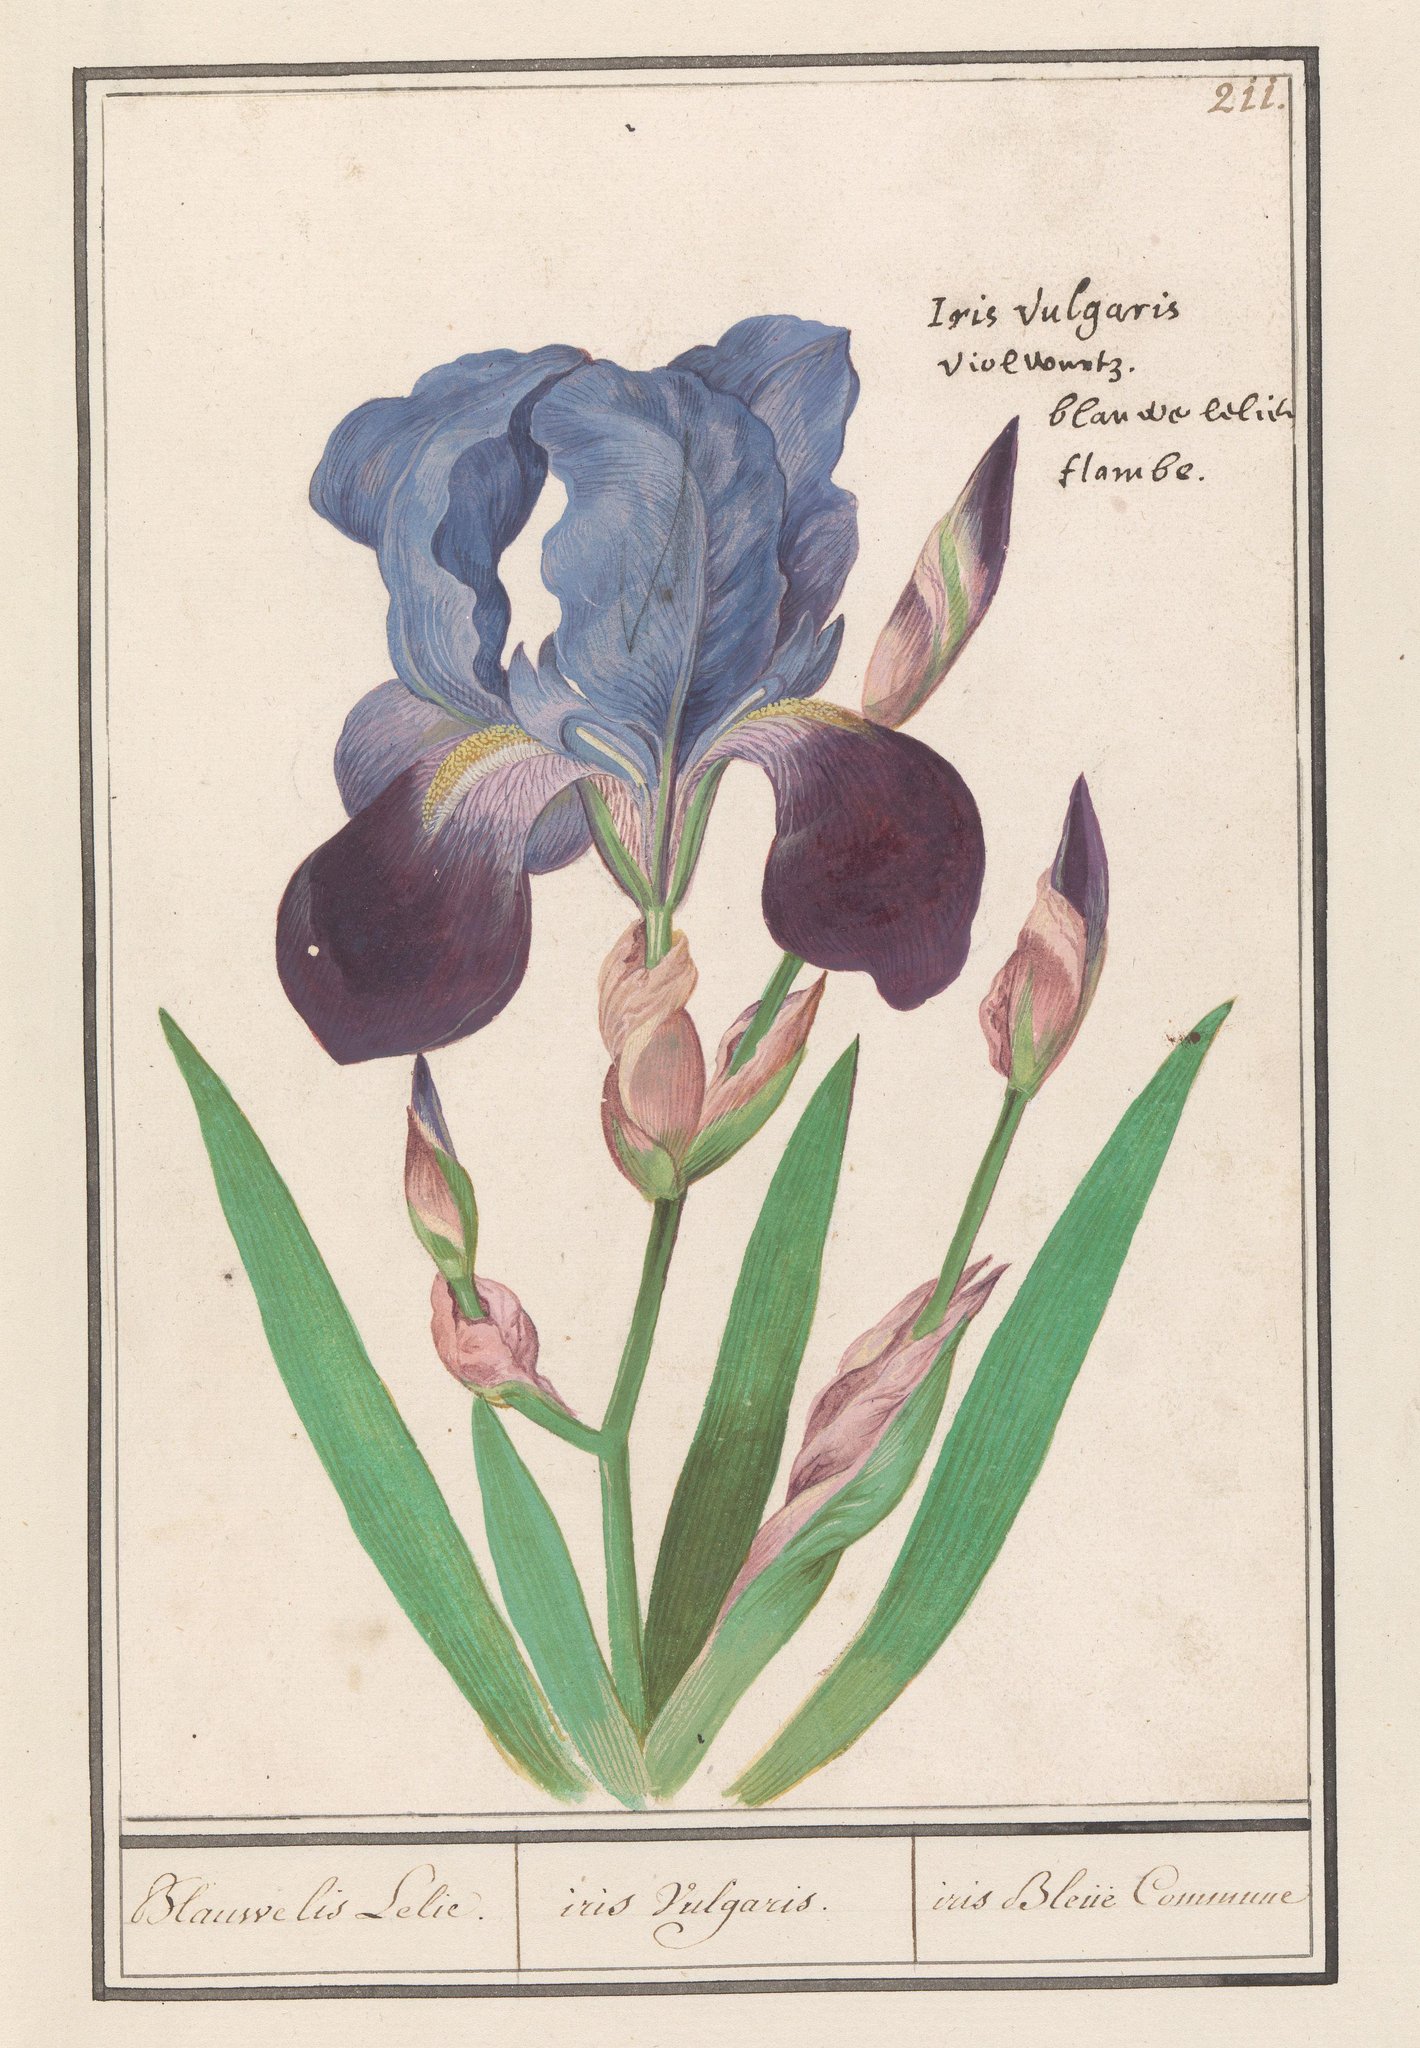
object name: drawing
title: Blauwe lis Lelie. / iris Vulgaris. / iris Blue Commune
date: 1596-1610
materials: chalk, paint, ink, paper, watercolor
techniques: brush, pen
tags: flowers: iris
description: Paarse iris. Genummerd rechtsboven: 211. Rechtsboven de naam in vier talen. Onderdeel van het derde album met tekeningen van bloemen en planten. Tiende van twaalf albums met tekeningen van dieren, vogels en planten bekend rond 1600, gemaakt in opdracht van keizer Rudolf II. Met toelichting in Nederlands, Latijn en Frans.